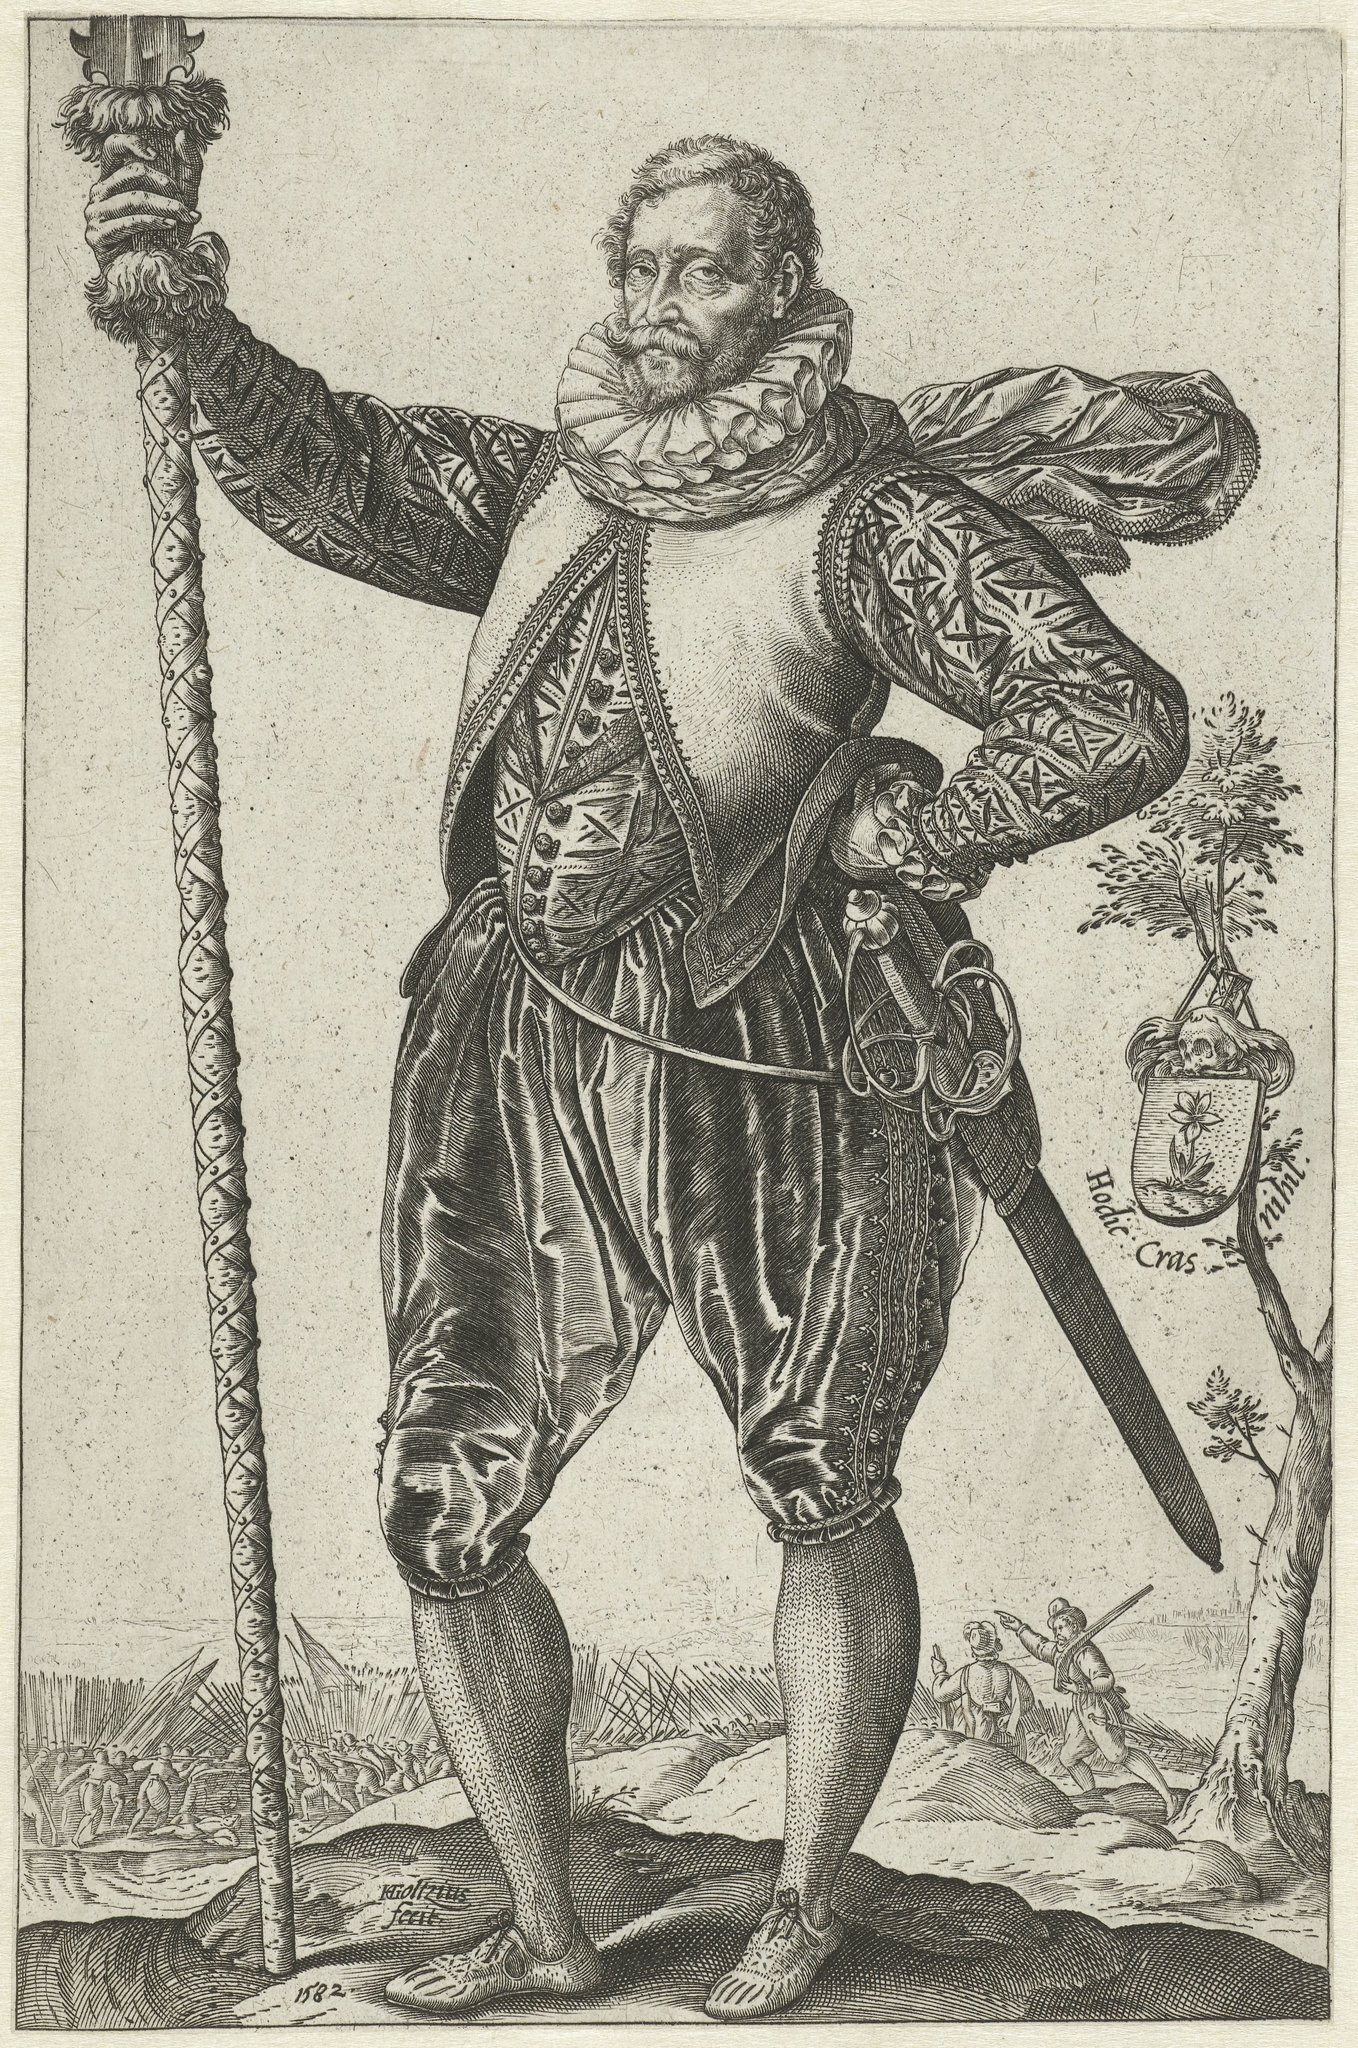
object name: print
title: Hodie: Cras nihil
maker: hendrick goltzius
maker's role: draughtsman, painter, print maker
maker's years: 1558-1617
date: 1582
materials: paper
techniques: engraving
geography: haarlem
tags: helved weapons, polearms (for striking, hacking, thrusting), 'vanitas' symbols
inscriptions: collector's mark: Lugt 2228a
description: Portret van een man met (waarschijnlijk) een partizaan (stokwapen) in zijn rechterhand. Voorheen ook wel geidentificeerd als Jan Dircksz. Schatter, kapitein te Haarlem. Rechts aan een boomstronk een schildje met een bloem erop en het motto 'Hodie: Cras nihil' eronder. Op de achtergrond een veldslag.